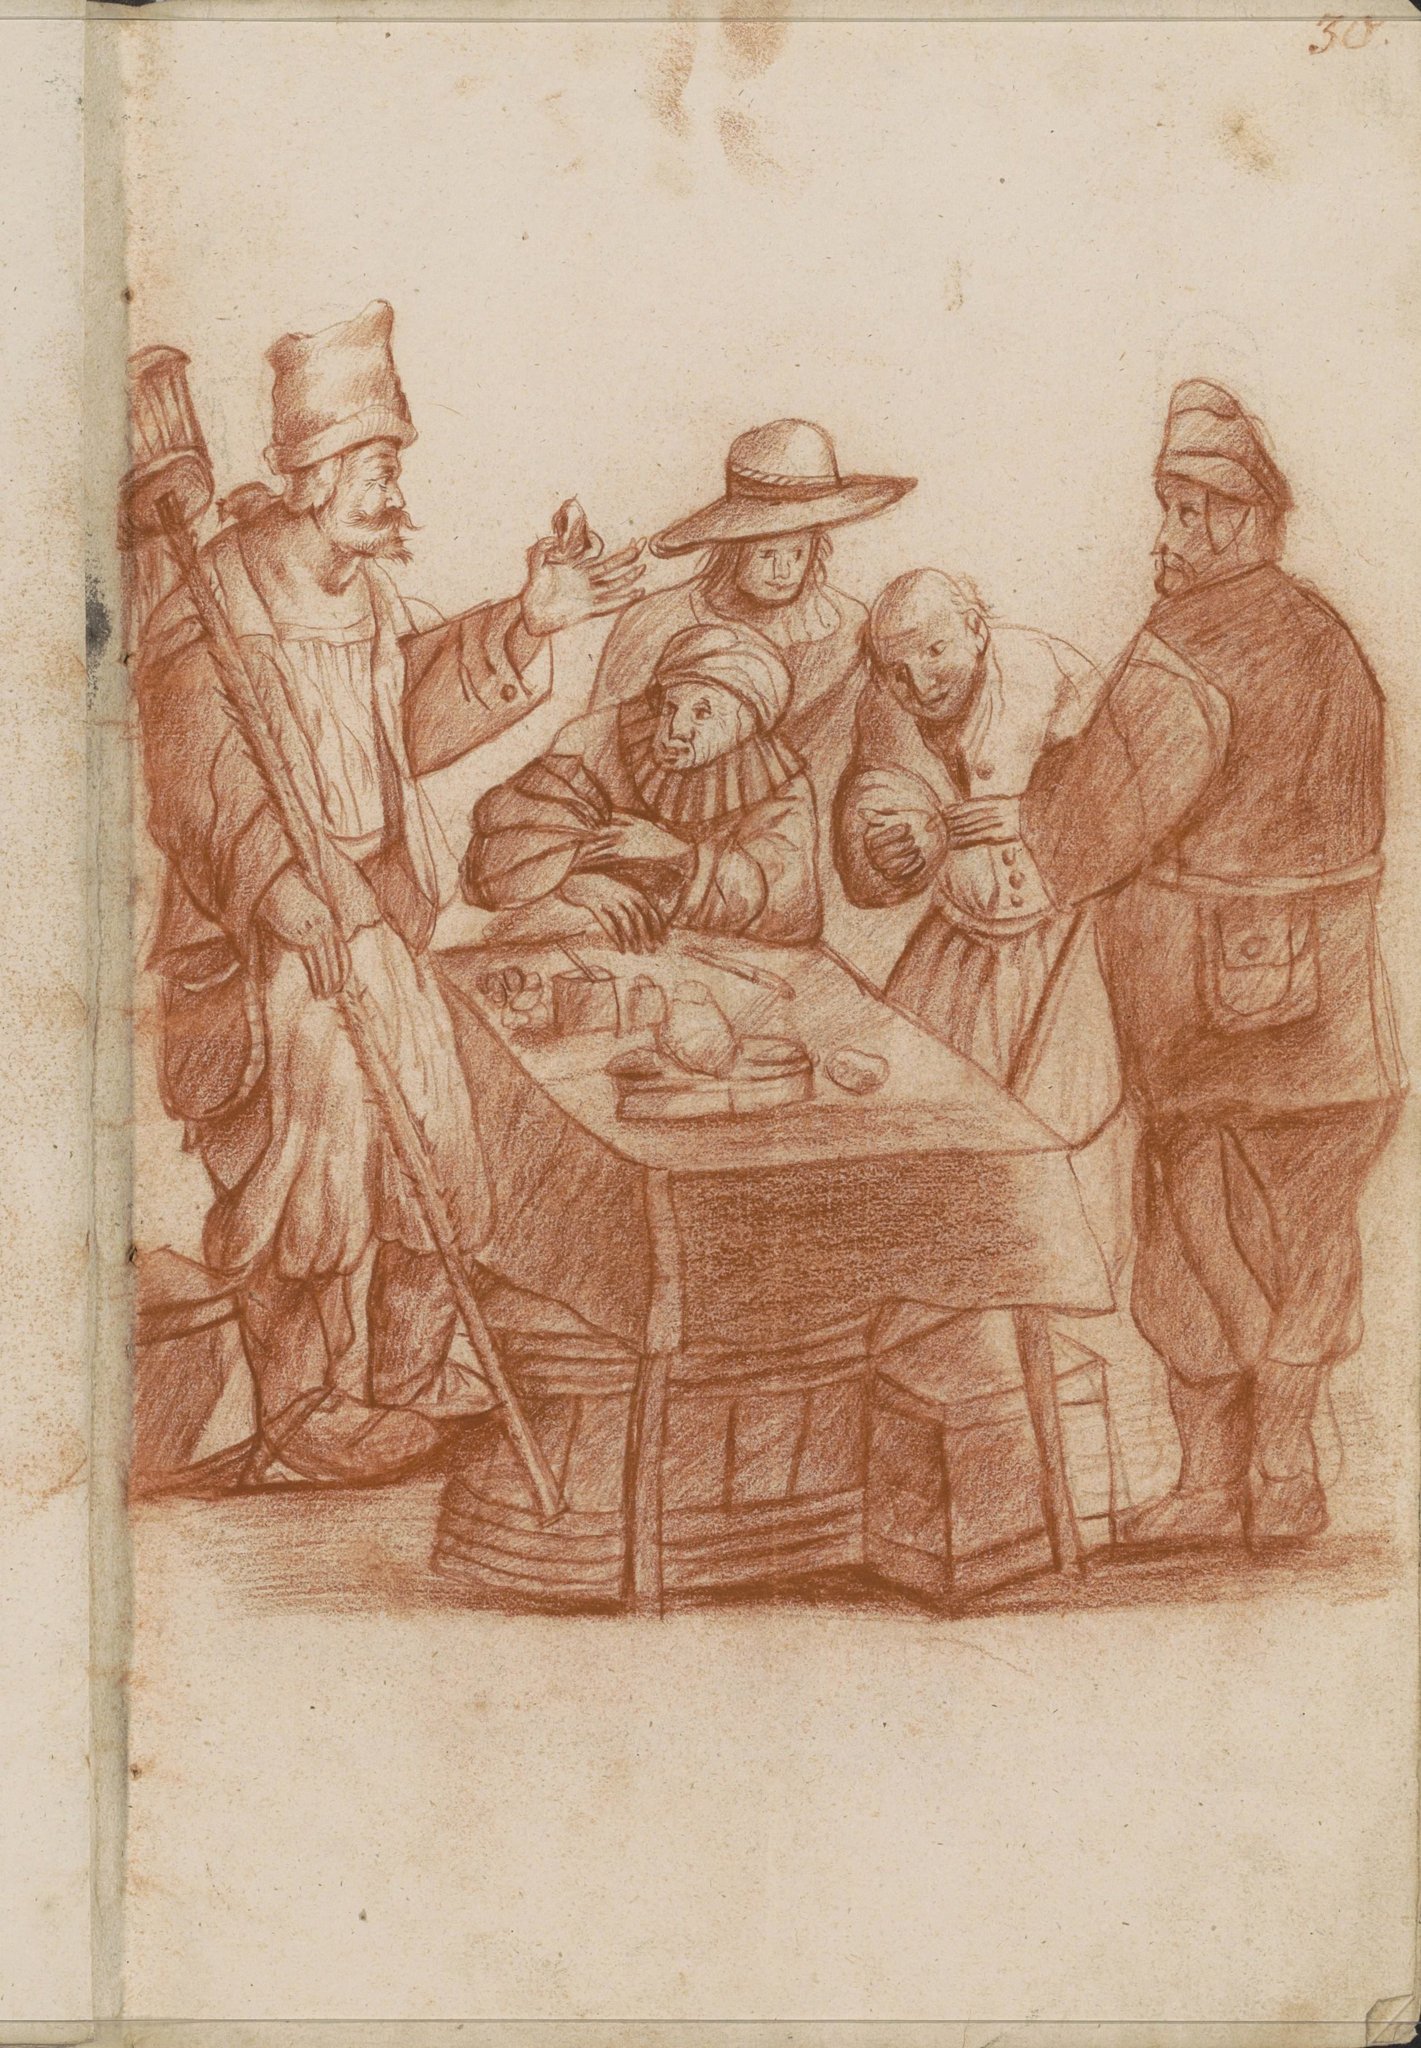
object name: sketchbook leaf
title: Vijf mannen rondom een tafel, vermoedelijk in een taveerne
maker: hendrick van beaumont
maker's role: draughtsman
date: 1696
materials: chalk, paper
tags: inn, coffee-house, public house, etc., table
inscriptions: number: ‘30’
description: Vermoedelijk getekend naar een prent. Blad 25 recto uit een schetsboek met 30 bladen.